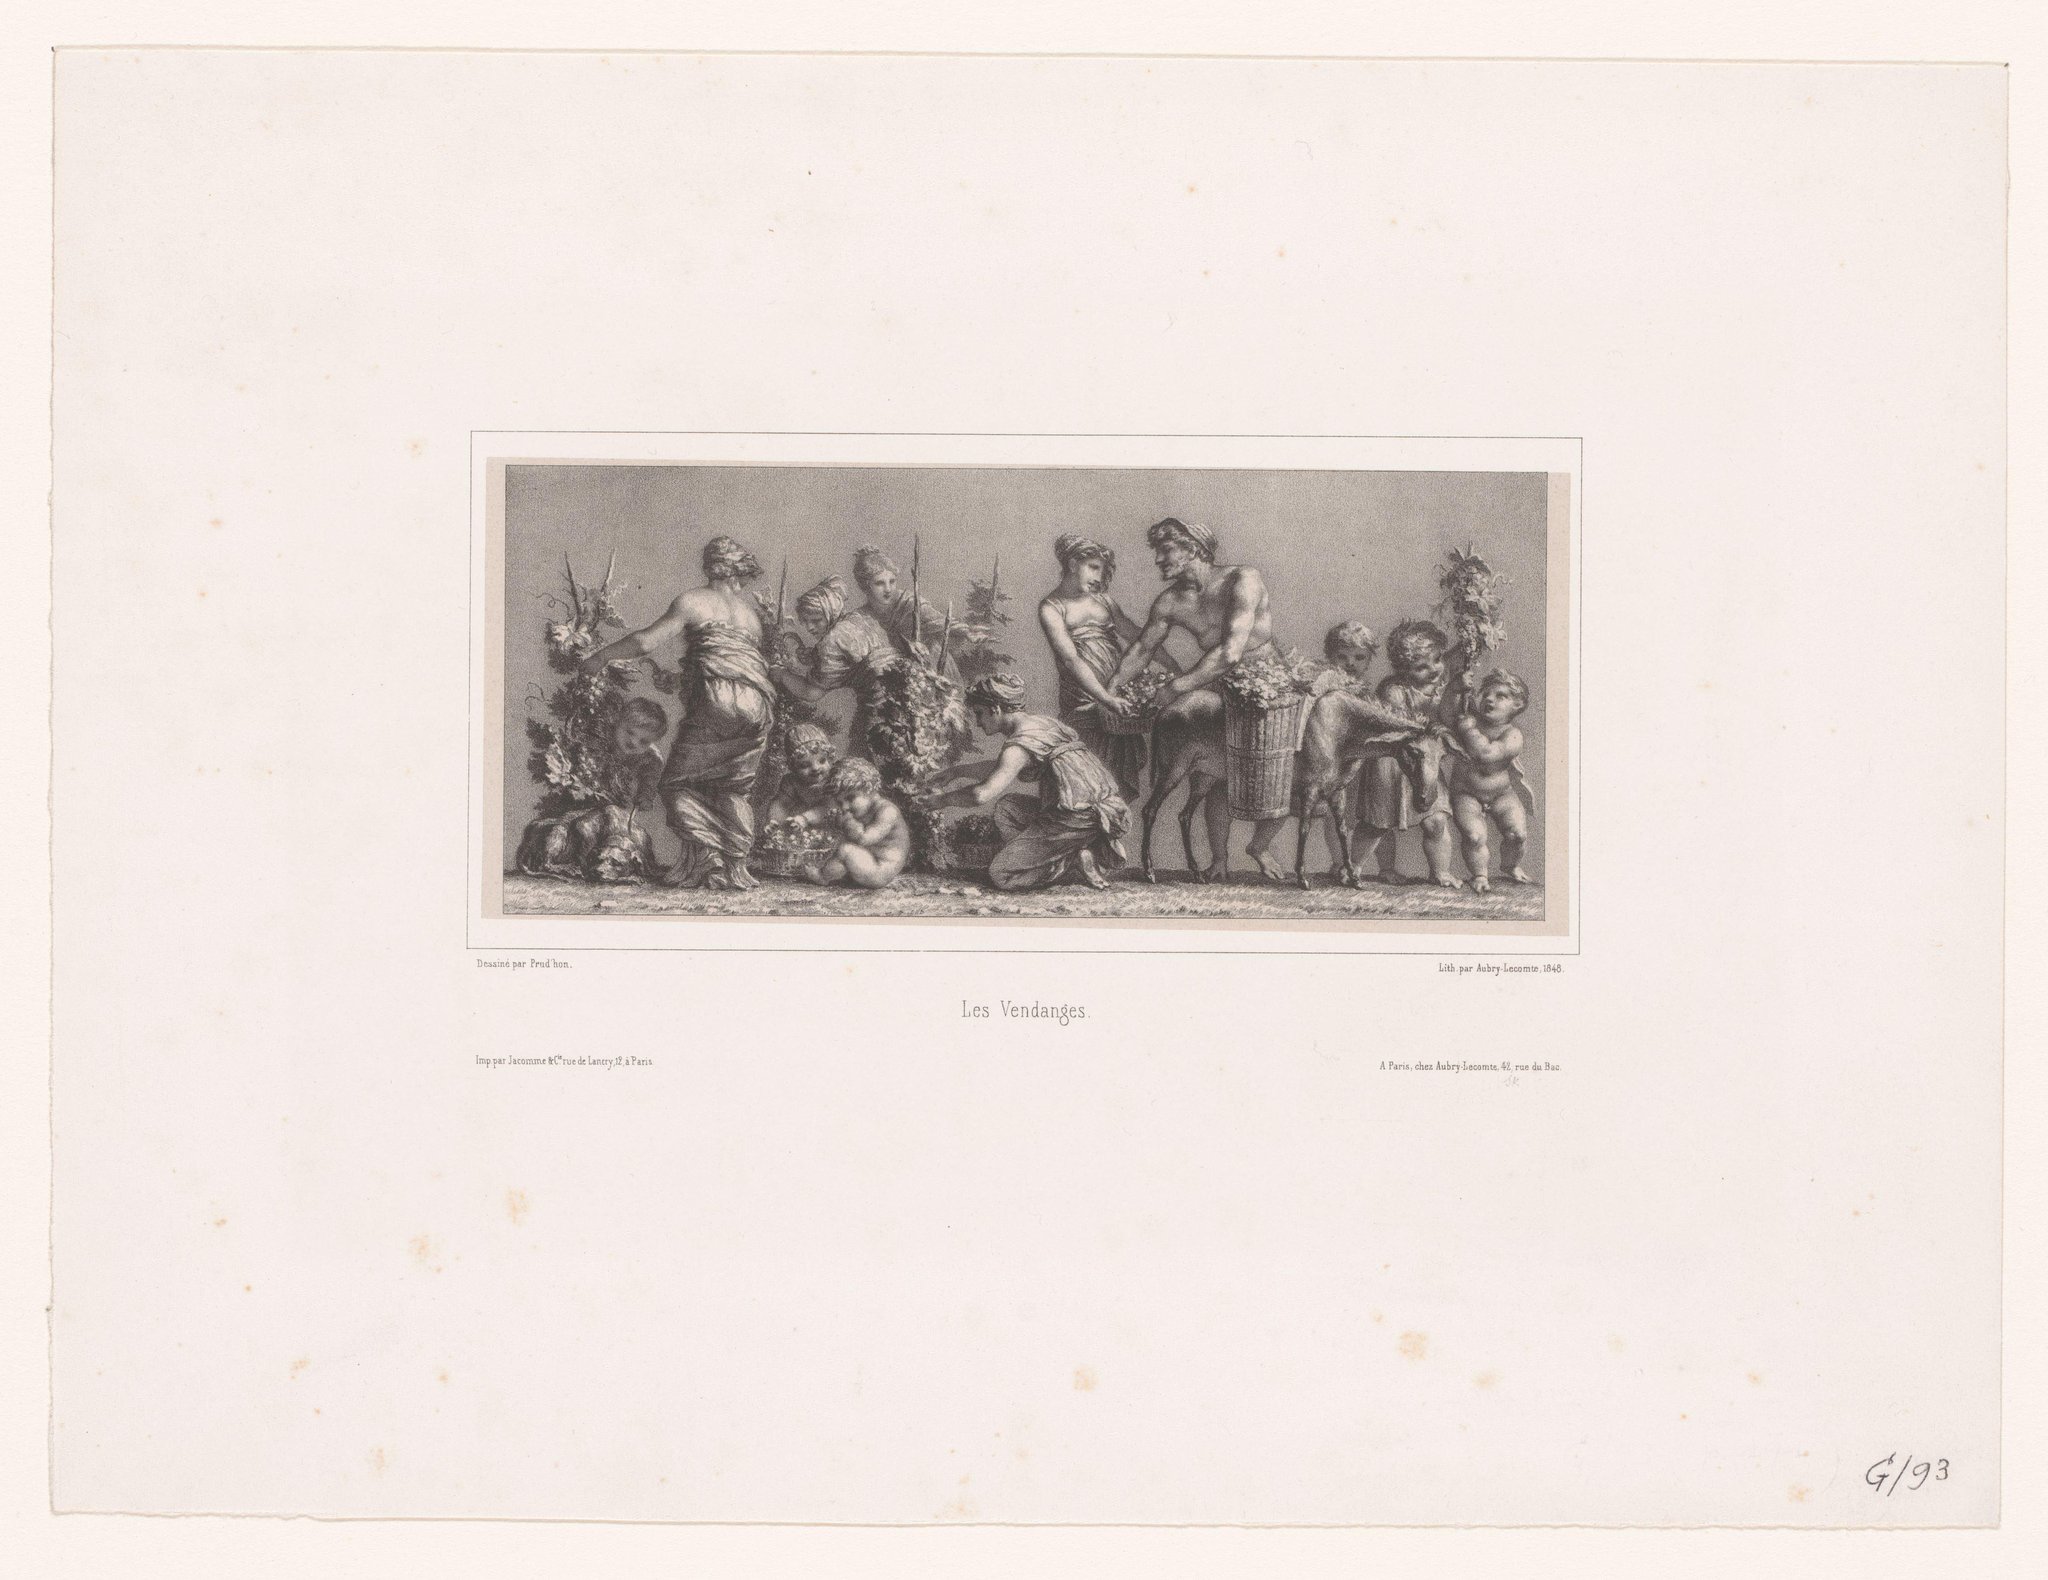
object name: print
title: Oogst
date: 1848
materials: paper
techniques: lithograph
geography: paris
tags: harvest, vintage, grape harvest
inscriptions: collector's mark: Lugt 2760, collector's mark: Lugt 2228